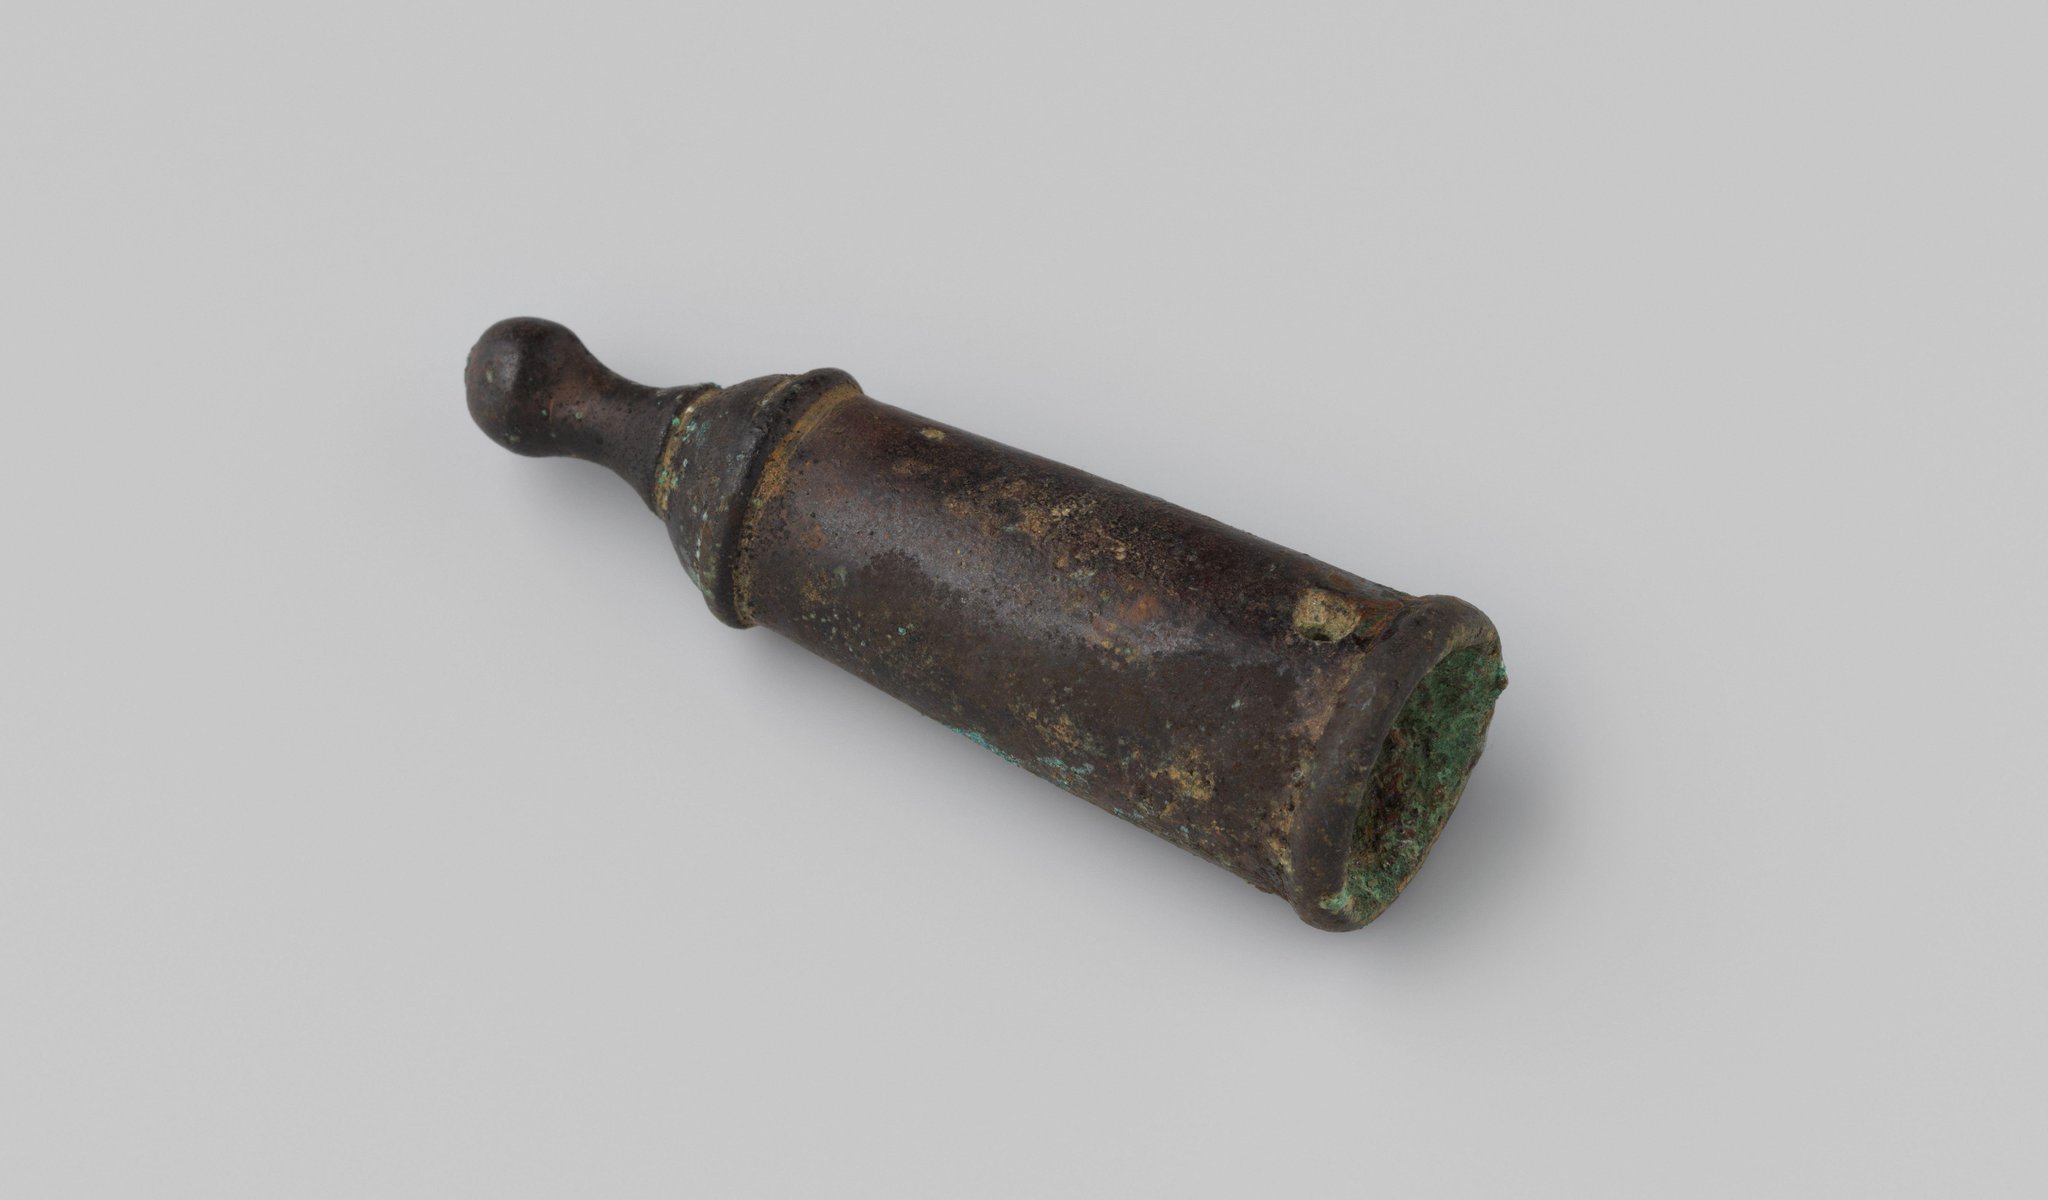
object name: clamp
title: Klem afkomstig uit het wrak van de Oost-Indiëvaarder Hollandia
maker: Anonymous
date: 1700-1743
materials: copper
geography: netherlands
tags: verenigde oostindische compagnie, hollandia (schip)